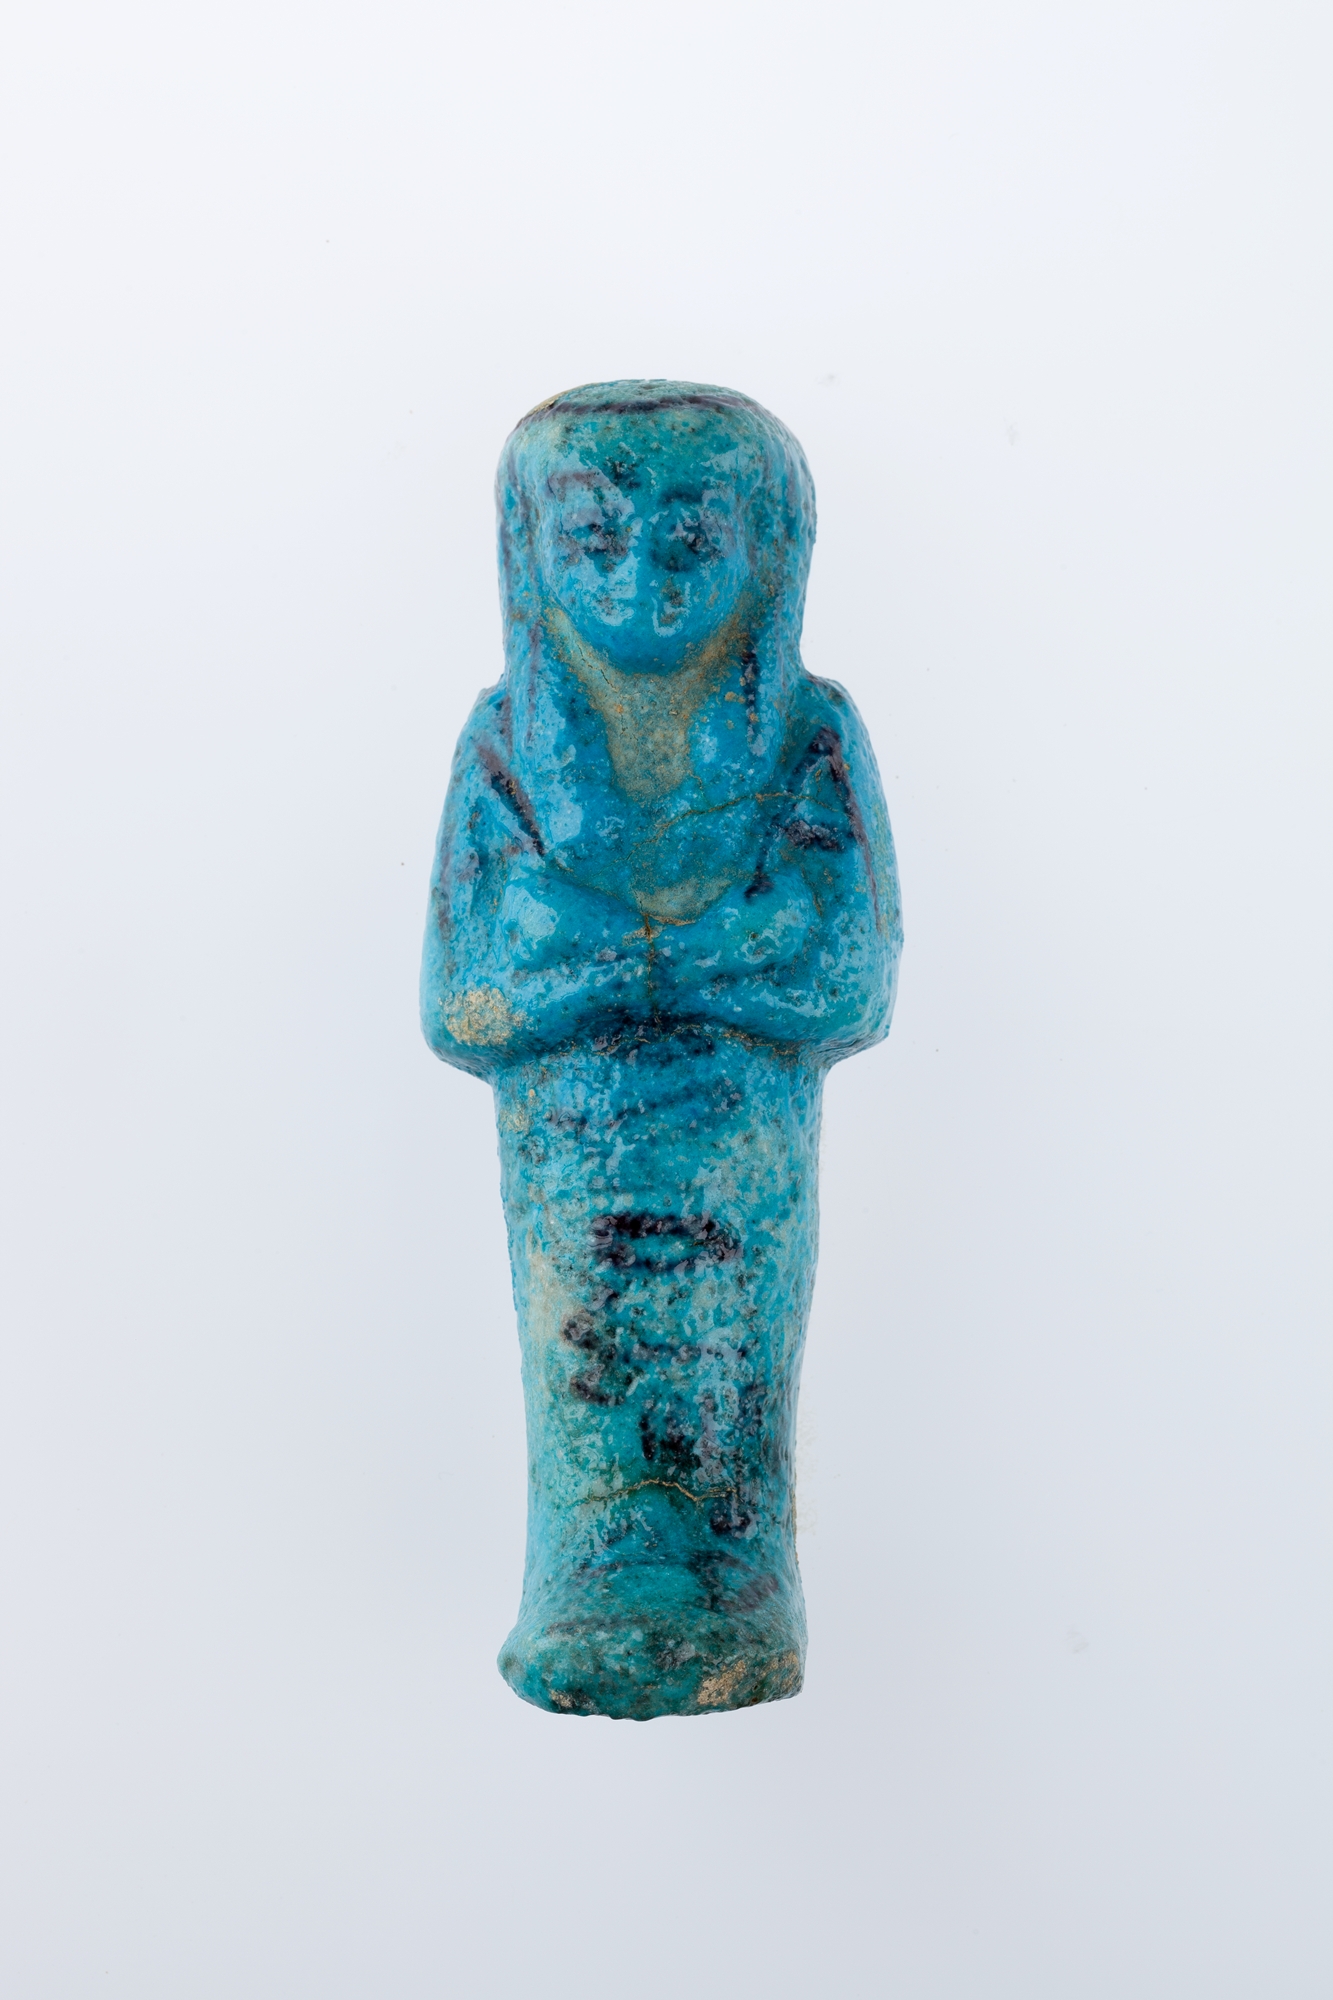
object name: shabti, henettawy c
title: Worker Shabti of Henettawy (C), Daughter of Isetemkheb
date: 990-970 BCE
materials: faience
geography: egypt